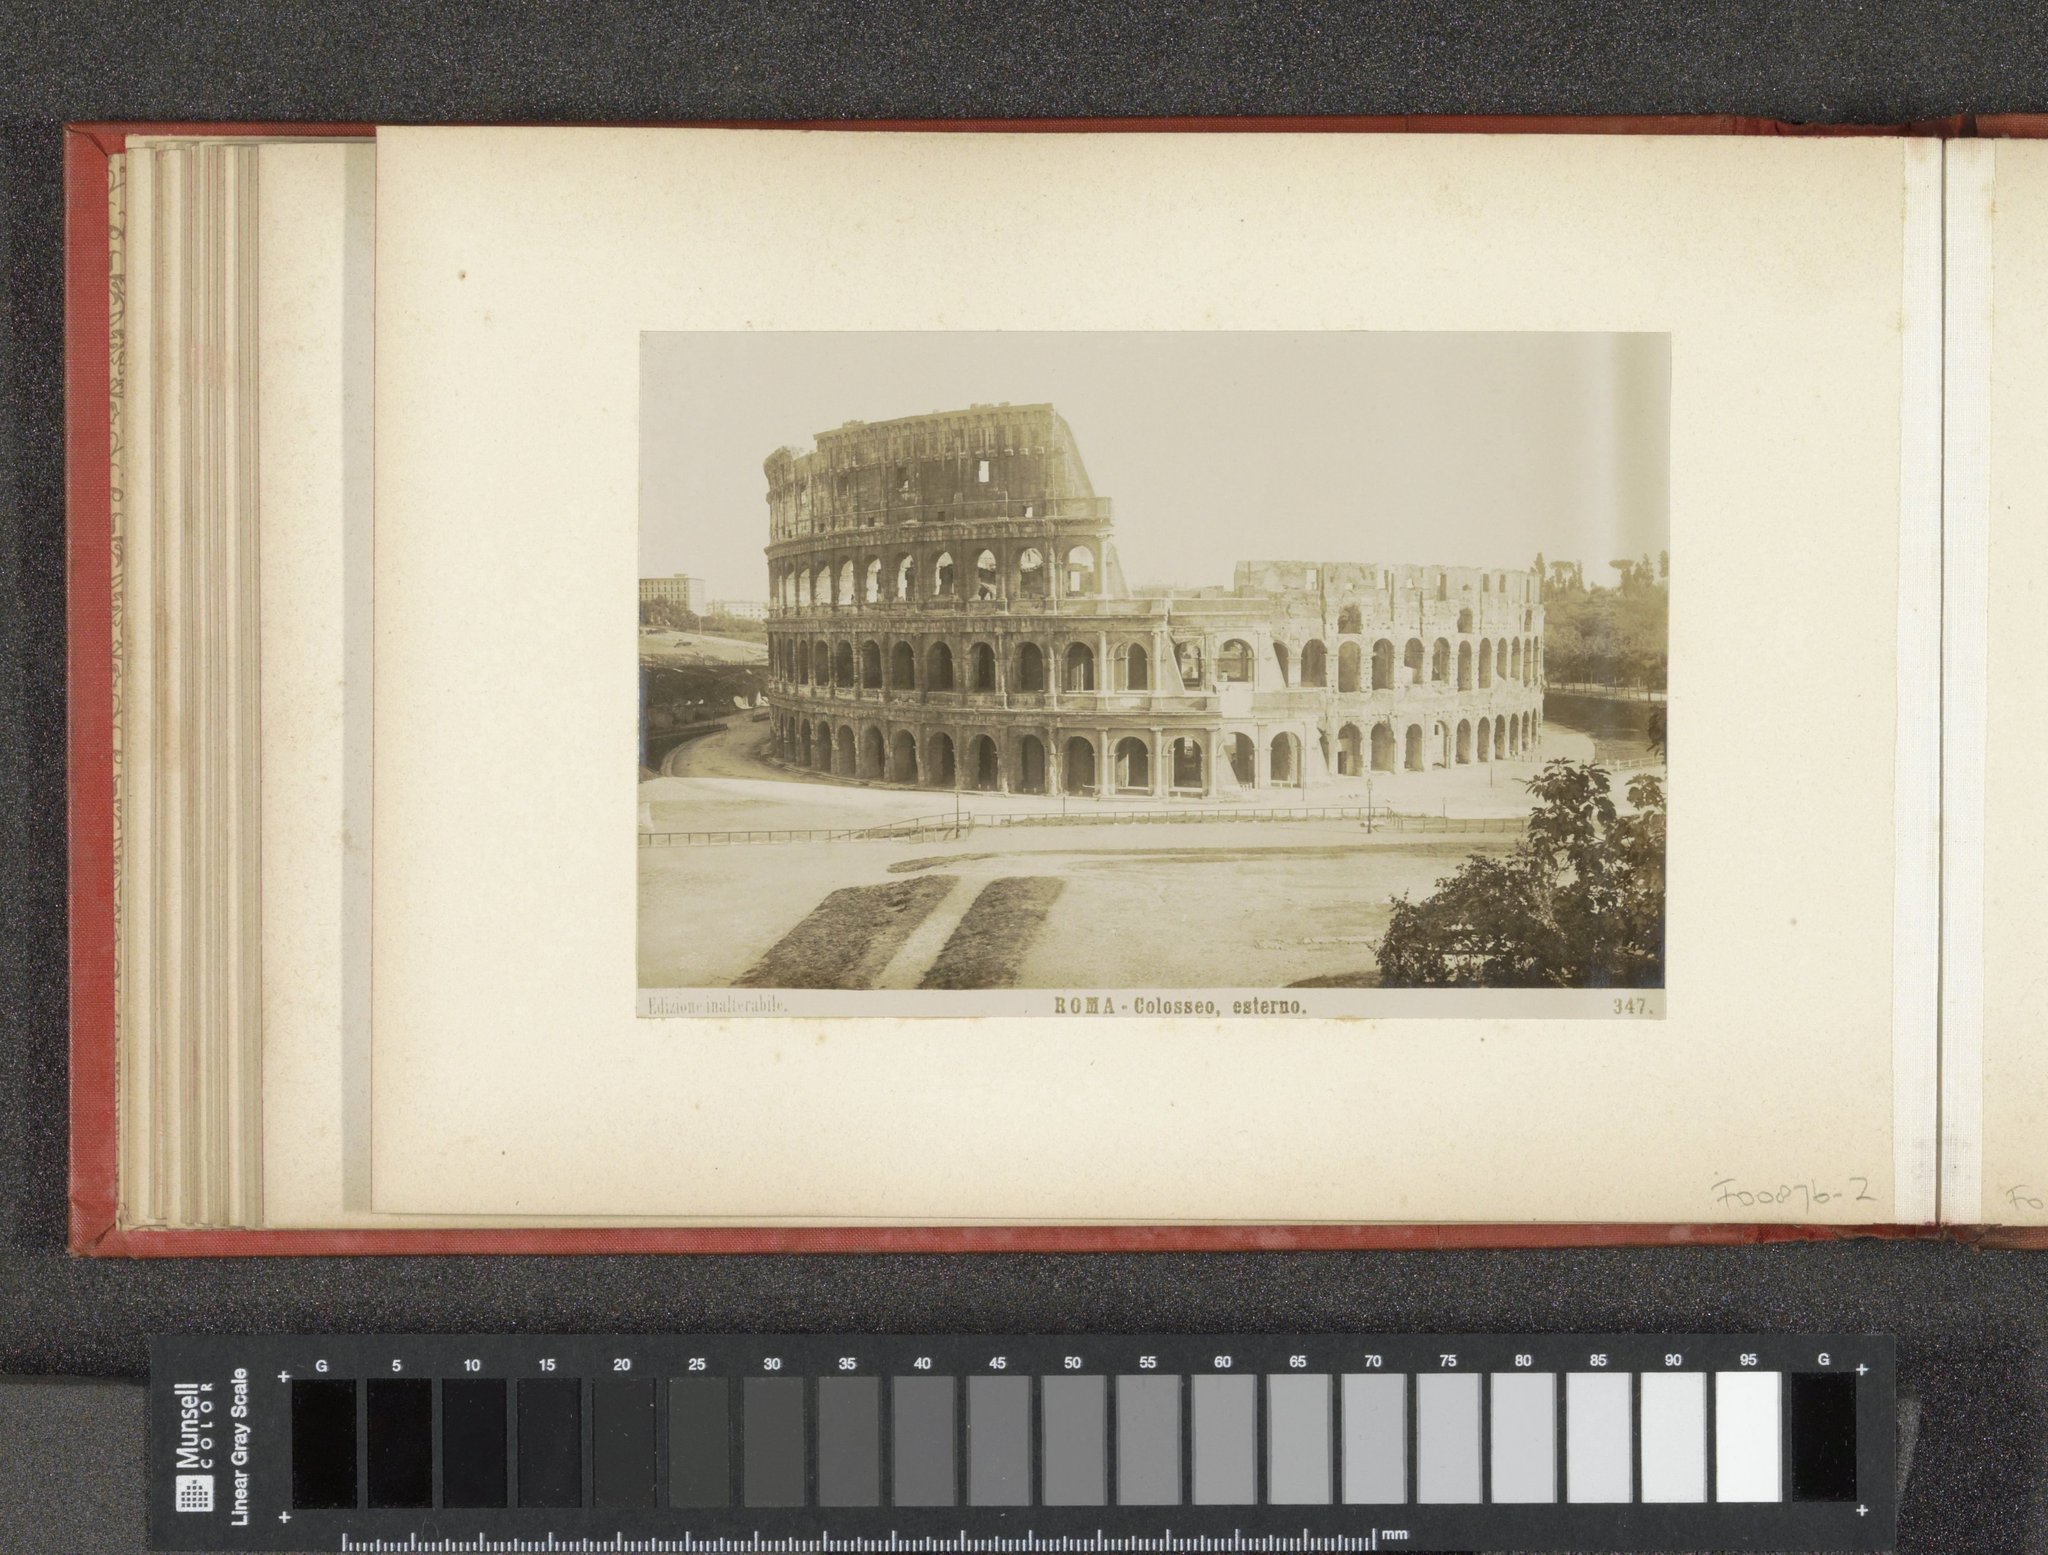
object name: photograph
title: Exterieur van het Colosseum in Rome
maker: Anonymous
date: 1860-1890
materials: cardboard, photographic support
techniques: gelatin silver print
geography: rome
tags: amphitheatre, grounds, fields and accomodations for sports, games and physical performances (+ out of doors (sports, games, etc.)), prospect of city, town panorama, silhouette of city, rome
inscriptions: number: ‘347’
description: Onderdeel van Fotoalbum met opnames van kerken, beelden en antieke gebouwen in Rome.